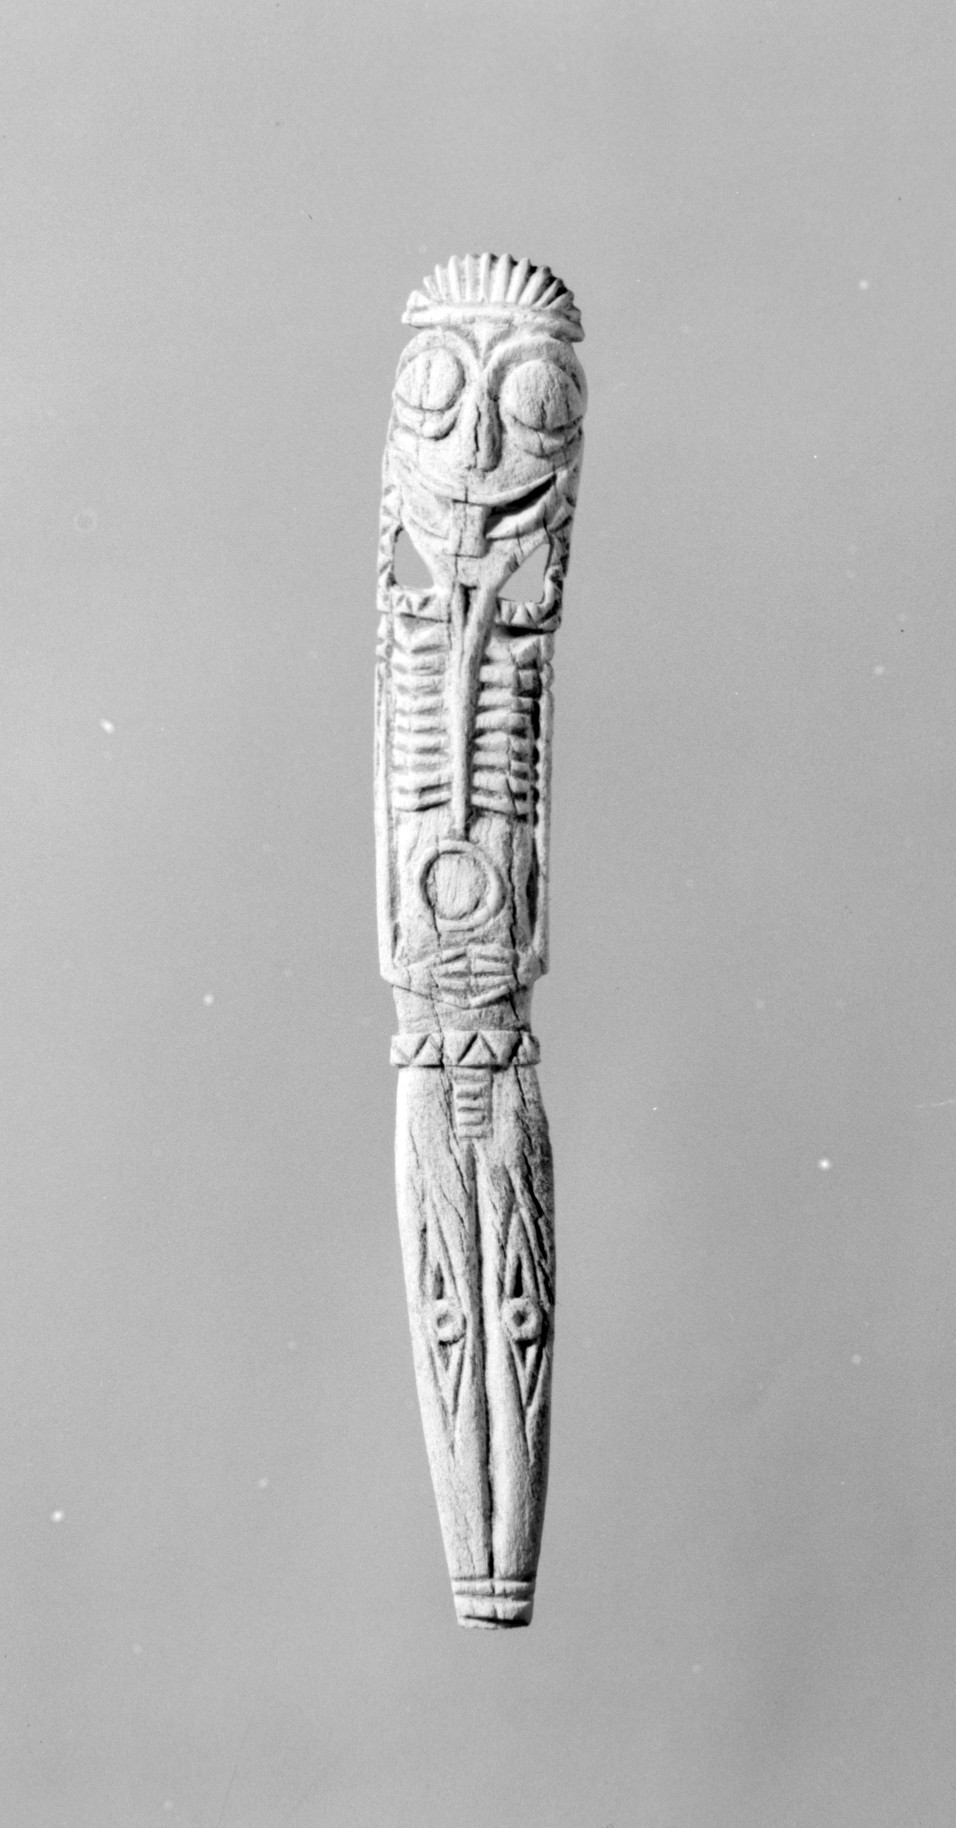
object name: figure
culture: columbia river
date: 1701-1800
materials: bone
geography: united states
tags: human figures